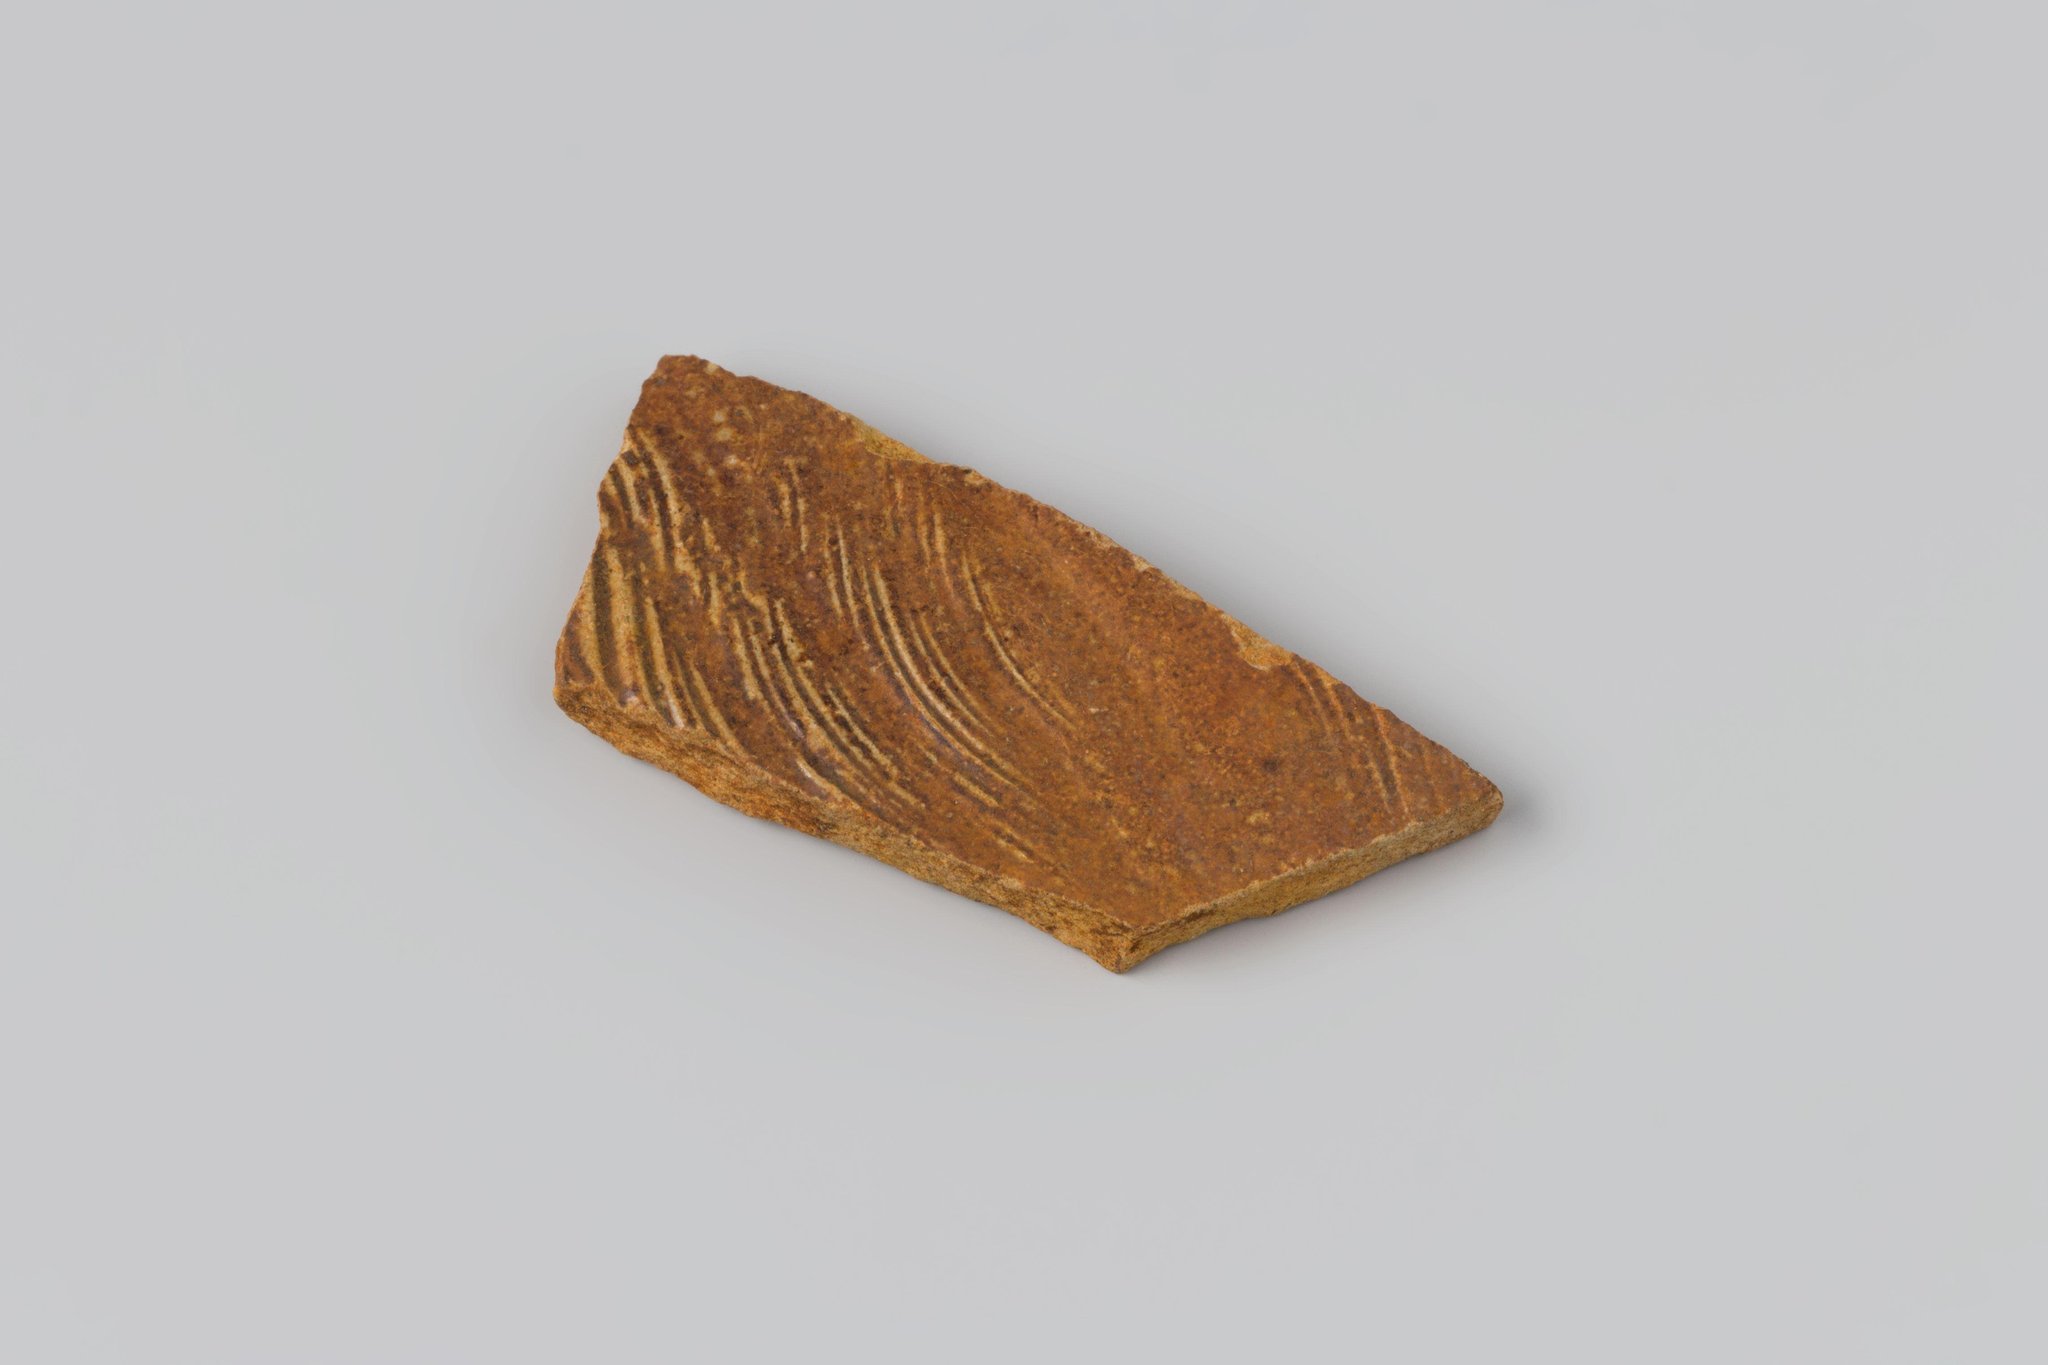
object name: sherd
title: Scherf van een voorraadpot uit het wrak van de Oost-Indiëvaarder Hollandia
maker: Anonymous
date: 1700-1743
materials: stoneware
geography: cologne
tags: verenigde oostindische compagnie, hollandia (schip), annet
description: Stoneware, Rhenish, Langerwehe-ware, storage-jar; fragm of body with wavy pattern, sim. NG 1980-27H909.